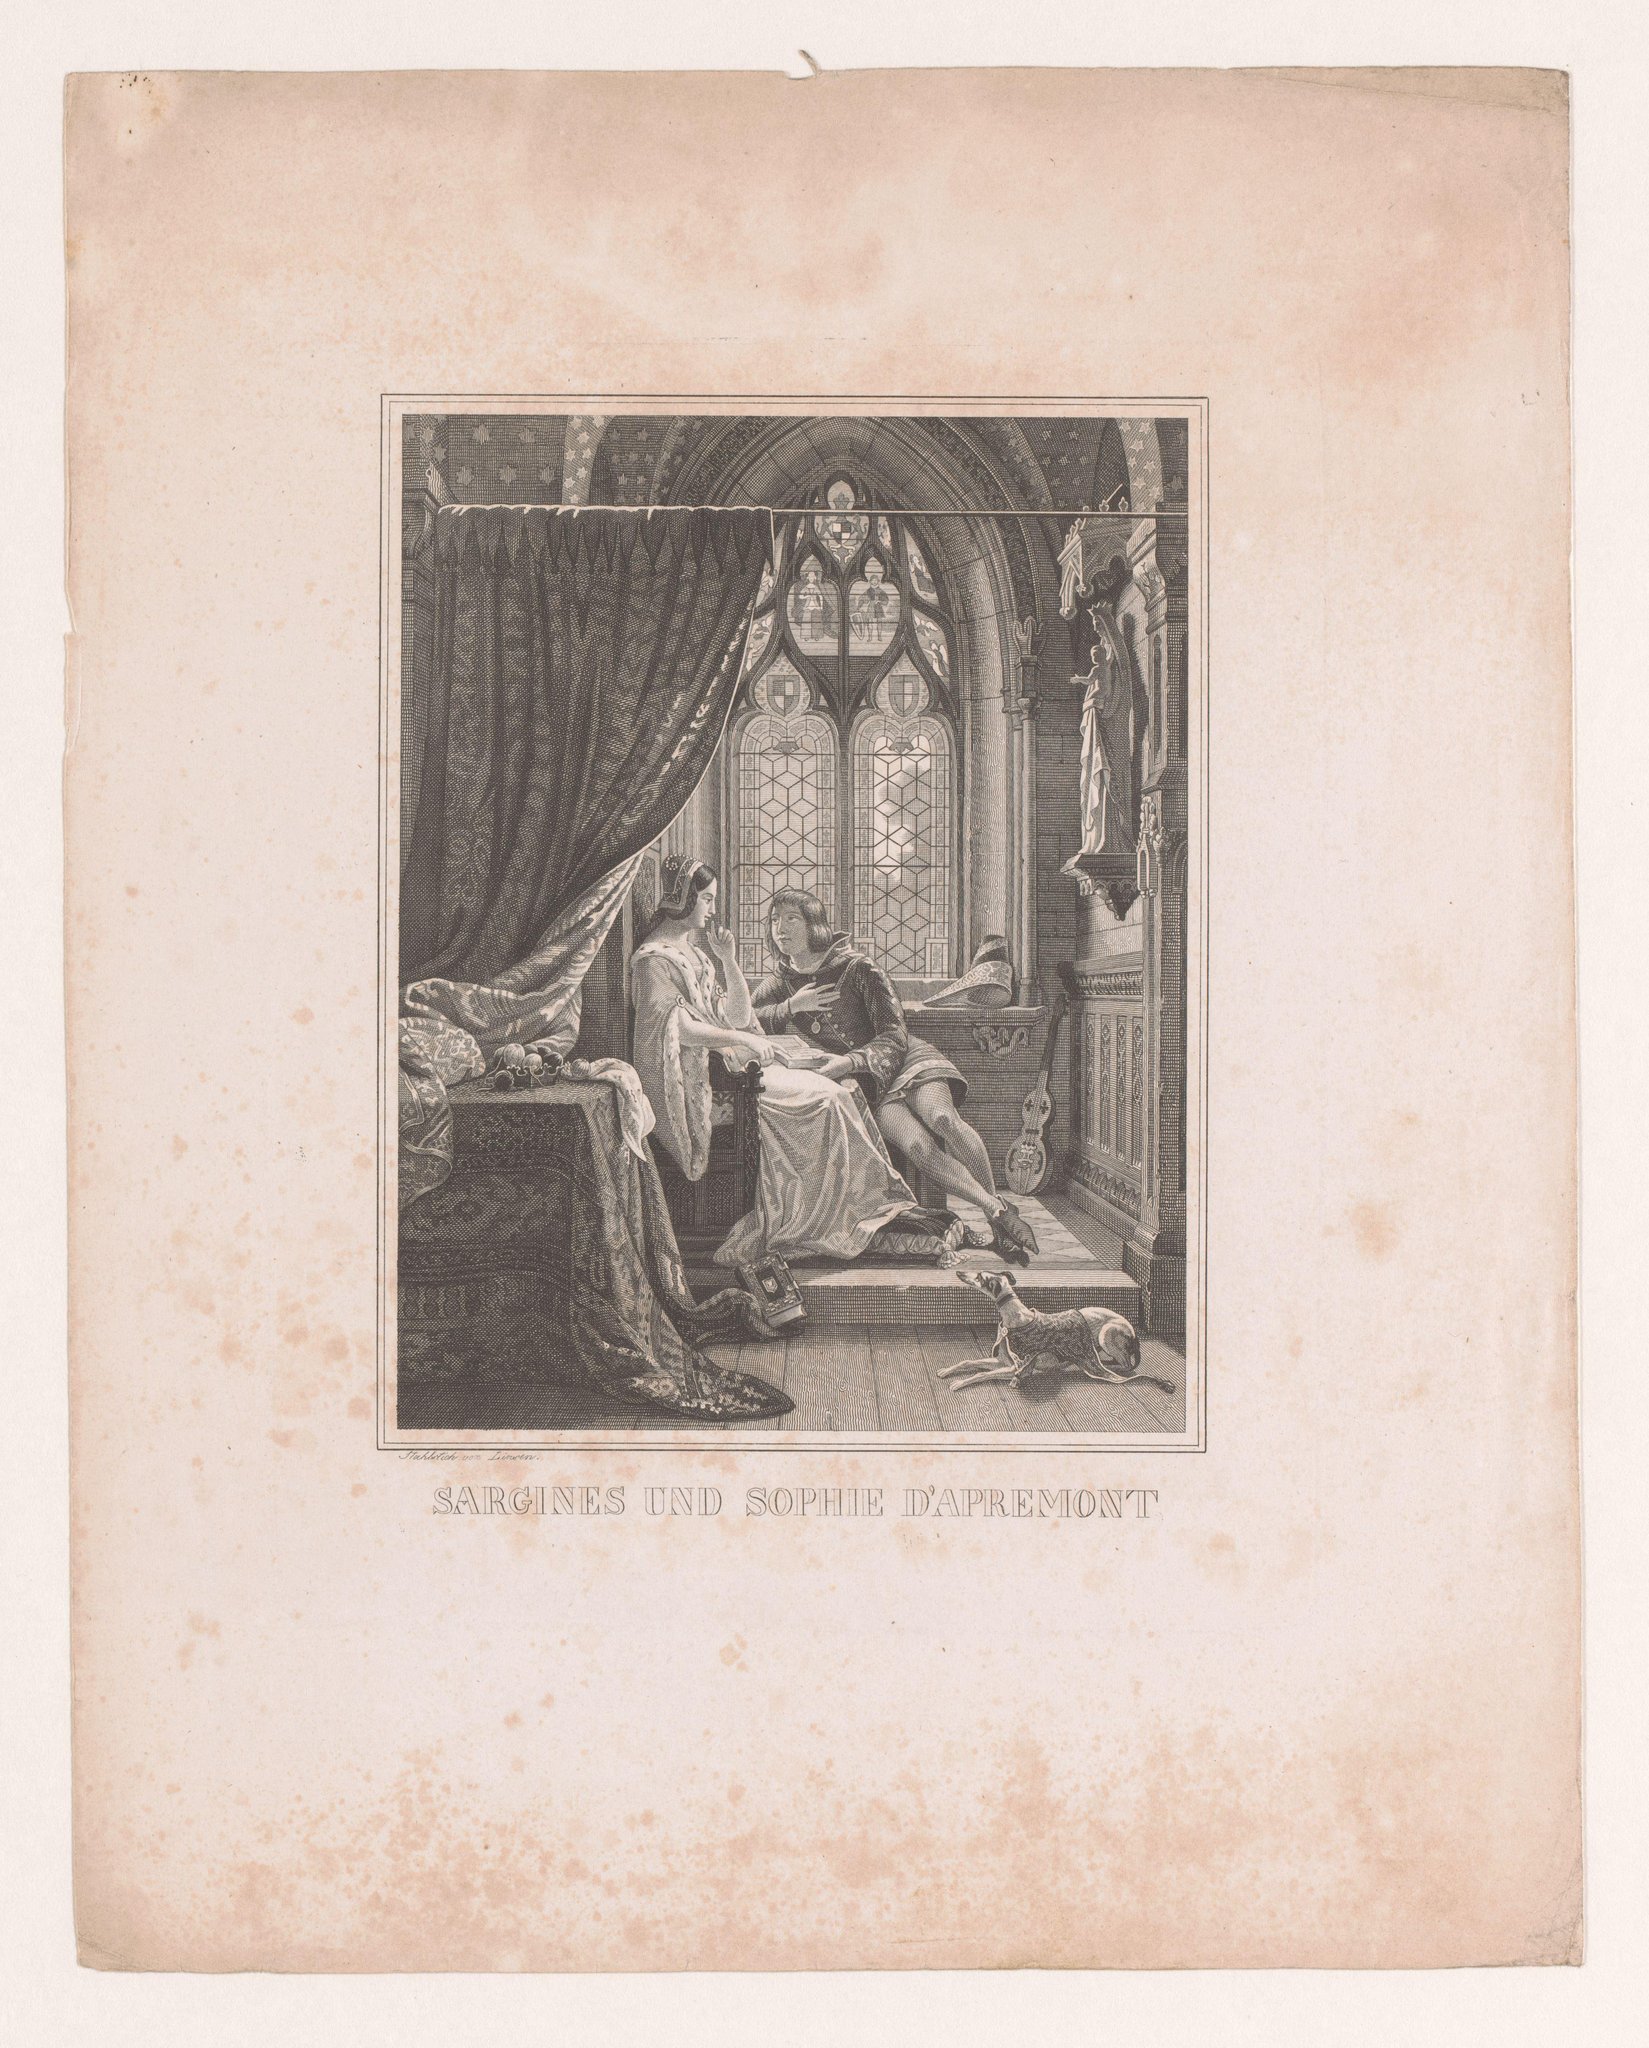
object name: print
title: Sargines und Sophie d'Apremont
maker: l. linsen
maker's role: print maker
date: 1839-1856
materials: paper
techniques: engraving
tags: curtains, chapel (interior of the house), awakening love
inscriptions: collector's mark: Lugt 2228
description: Deze voorstelling is geïnspireerd op het verhaal door P. Cuisin getiteld 'Sargines et Sophie d'Apremont, ou l'élève de l'amour. Anecdote française, tirée de la chevalerie', uitgegeven door Pierre-Mathieu-Henri Vauquelin in 1818.